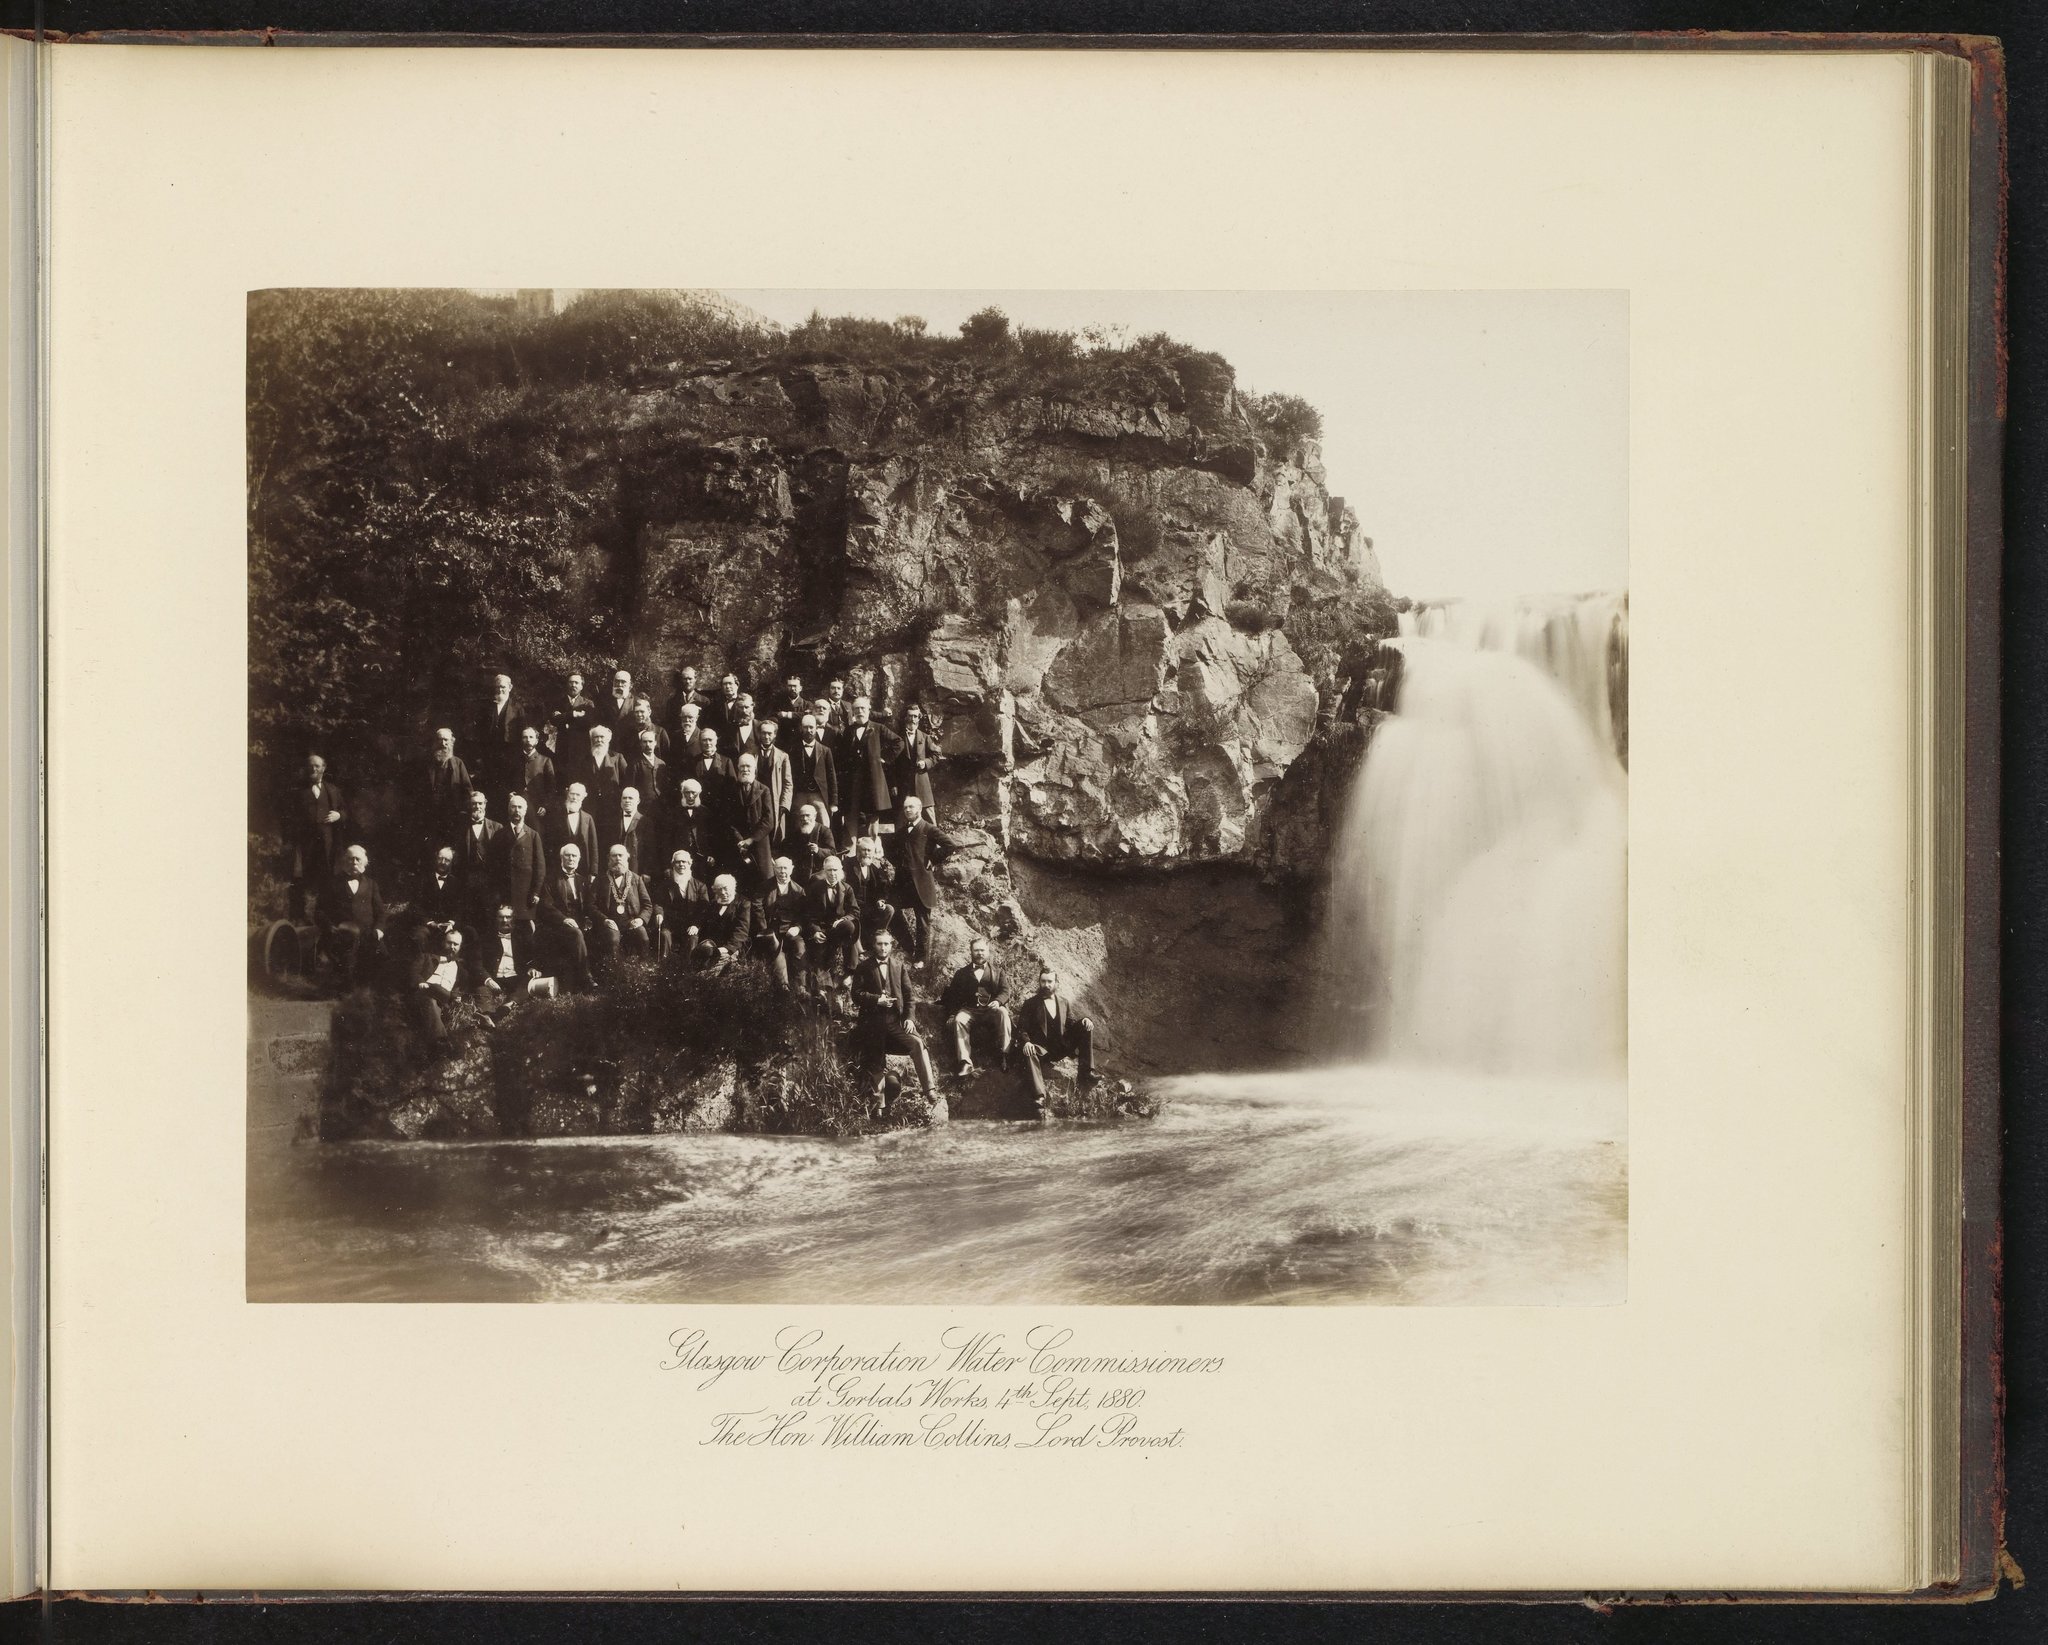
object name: page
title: Glasgow Corporation Water Commissioners at Gorbals Works 4th Sept. 1880. The Hon. William Collins, Lord Provost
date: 1880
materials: photographic support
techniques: albumen print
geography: scottish highlands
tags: waterfall, committee members, board members, anonymous historical persons portrayed in a group, in a group-portrait